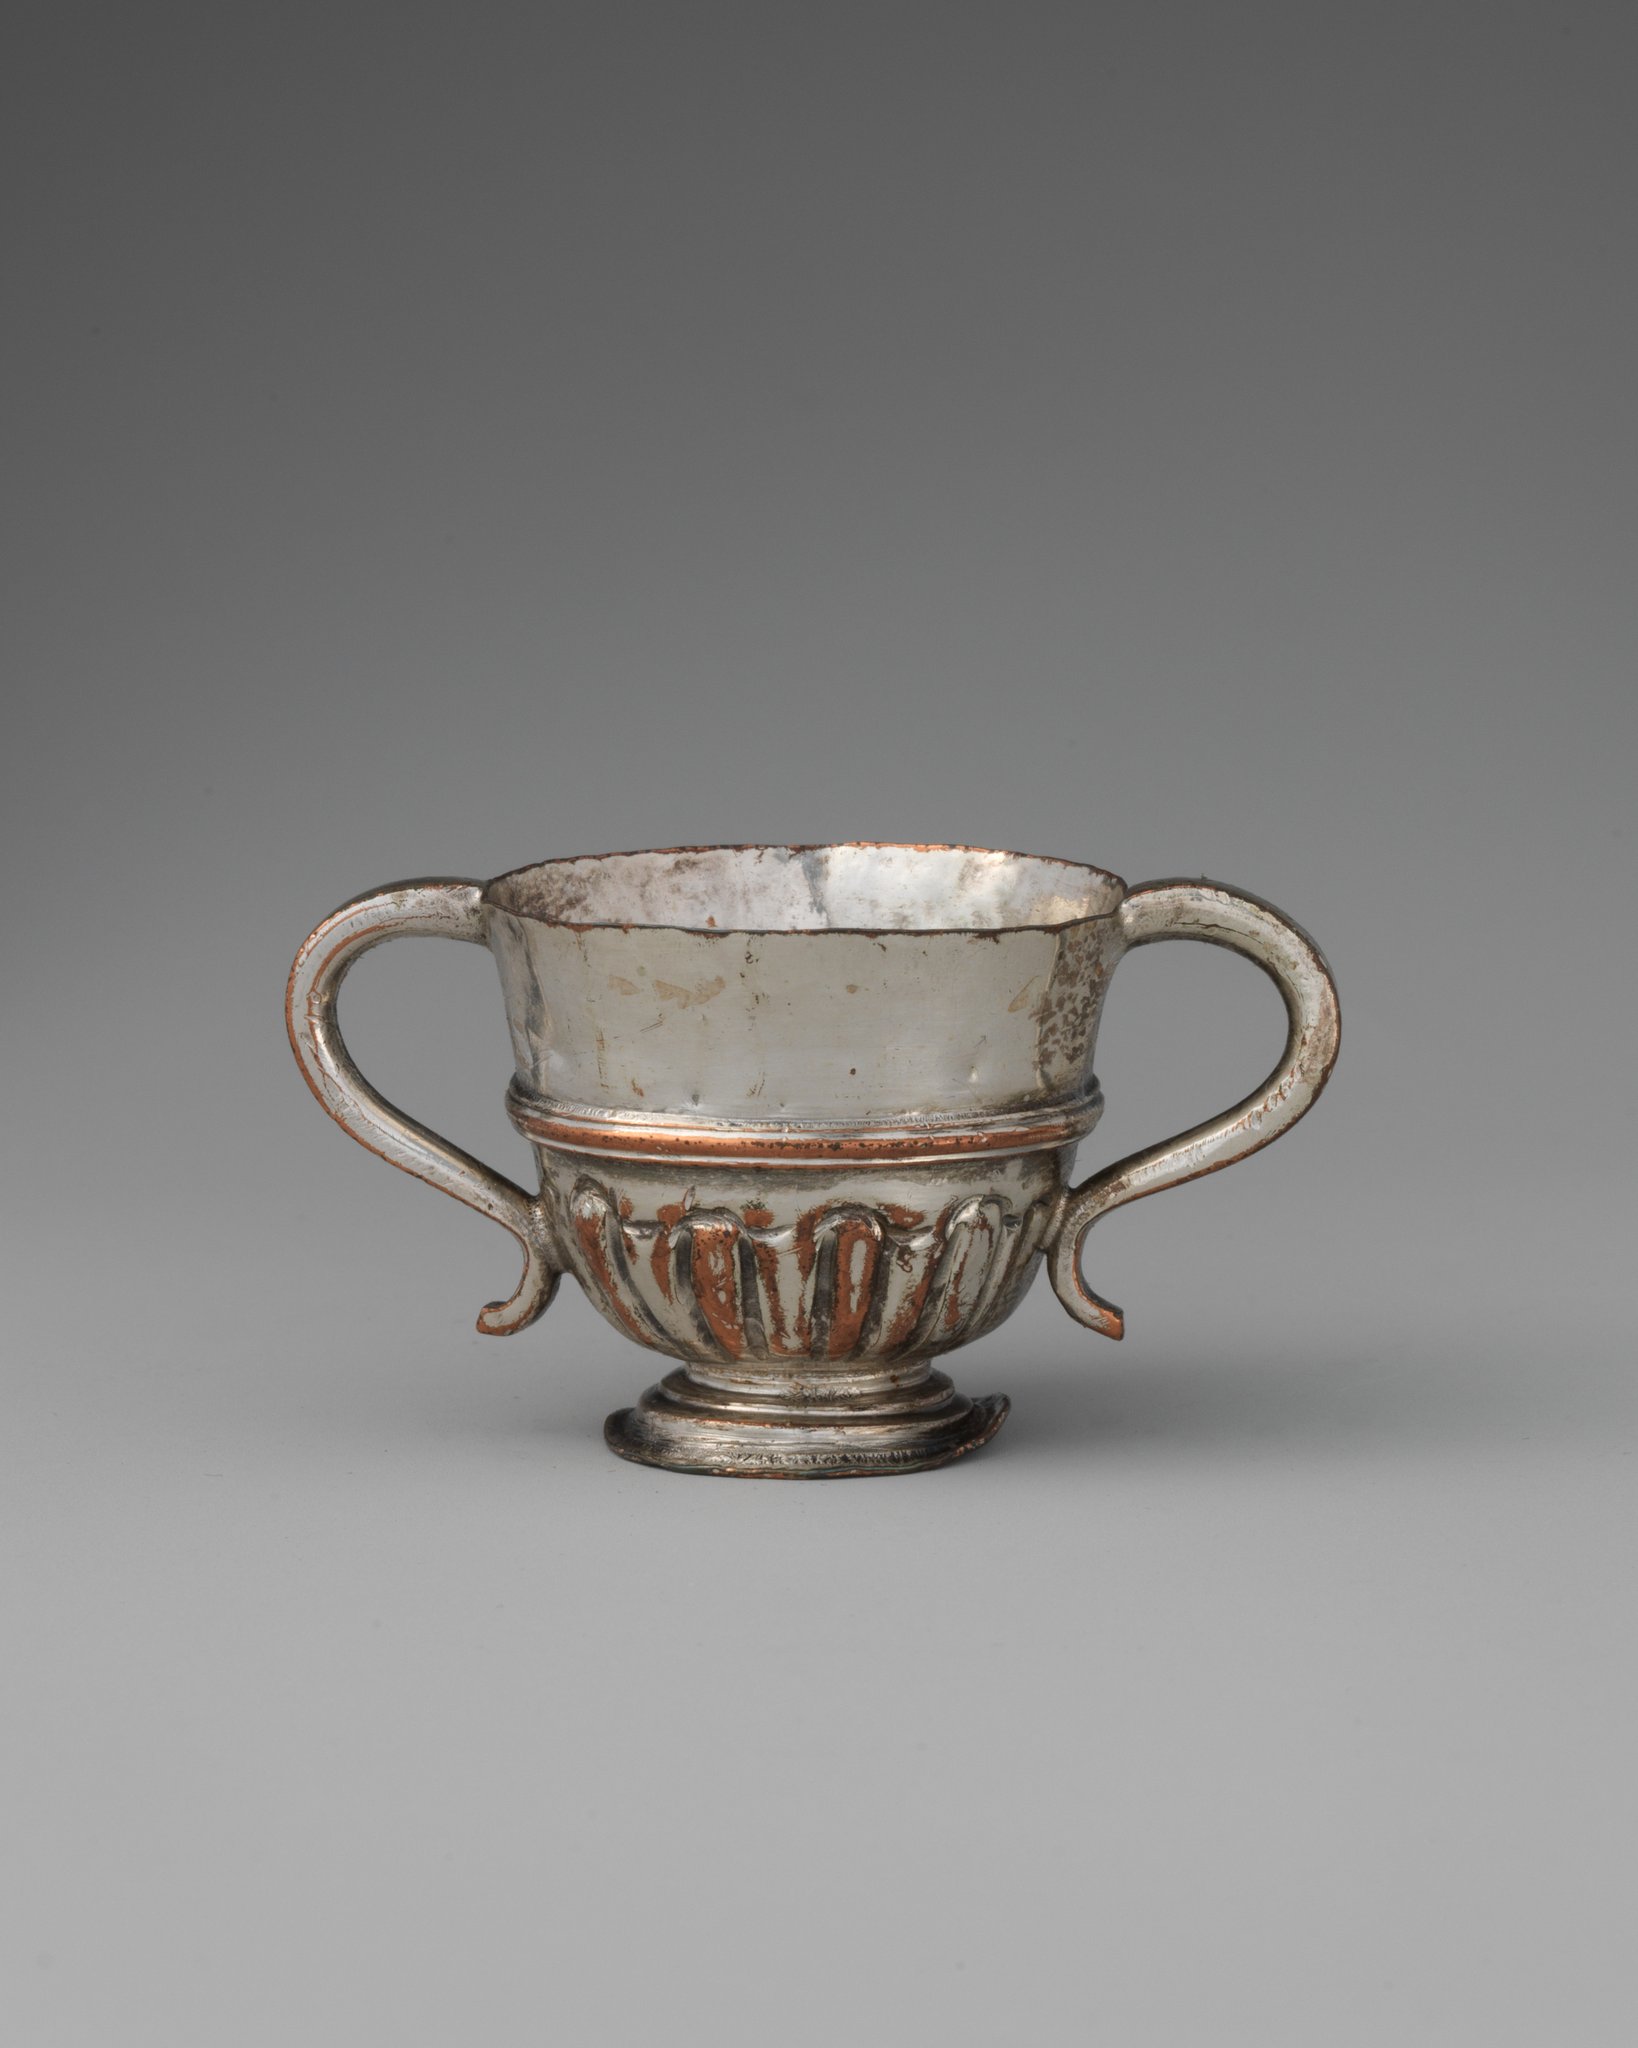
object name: cup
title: Miniature cup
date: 1767-1800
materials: copper, silver